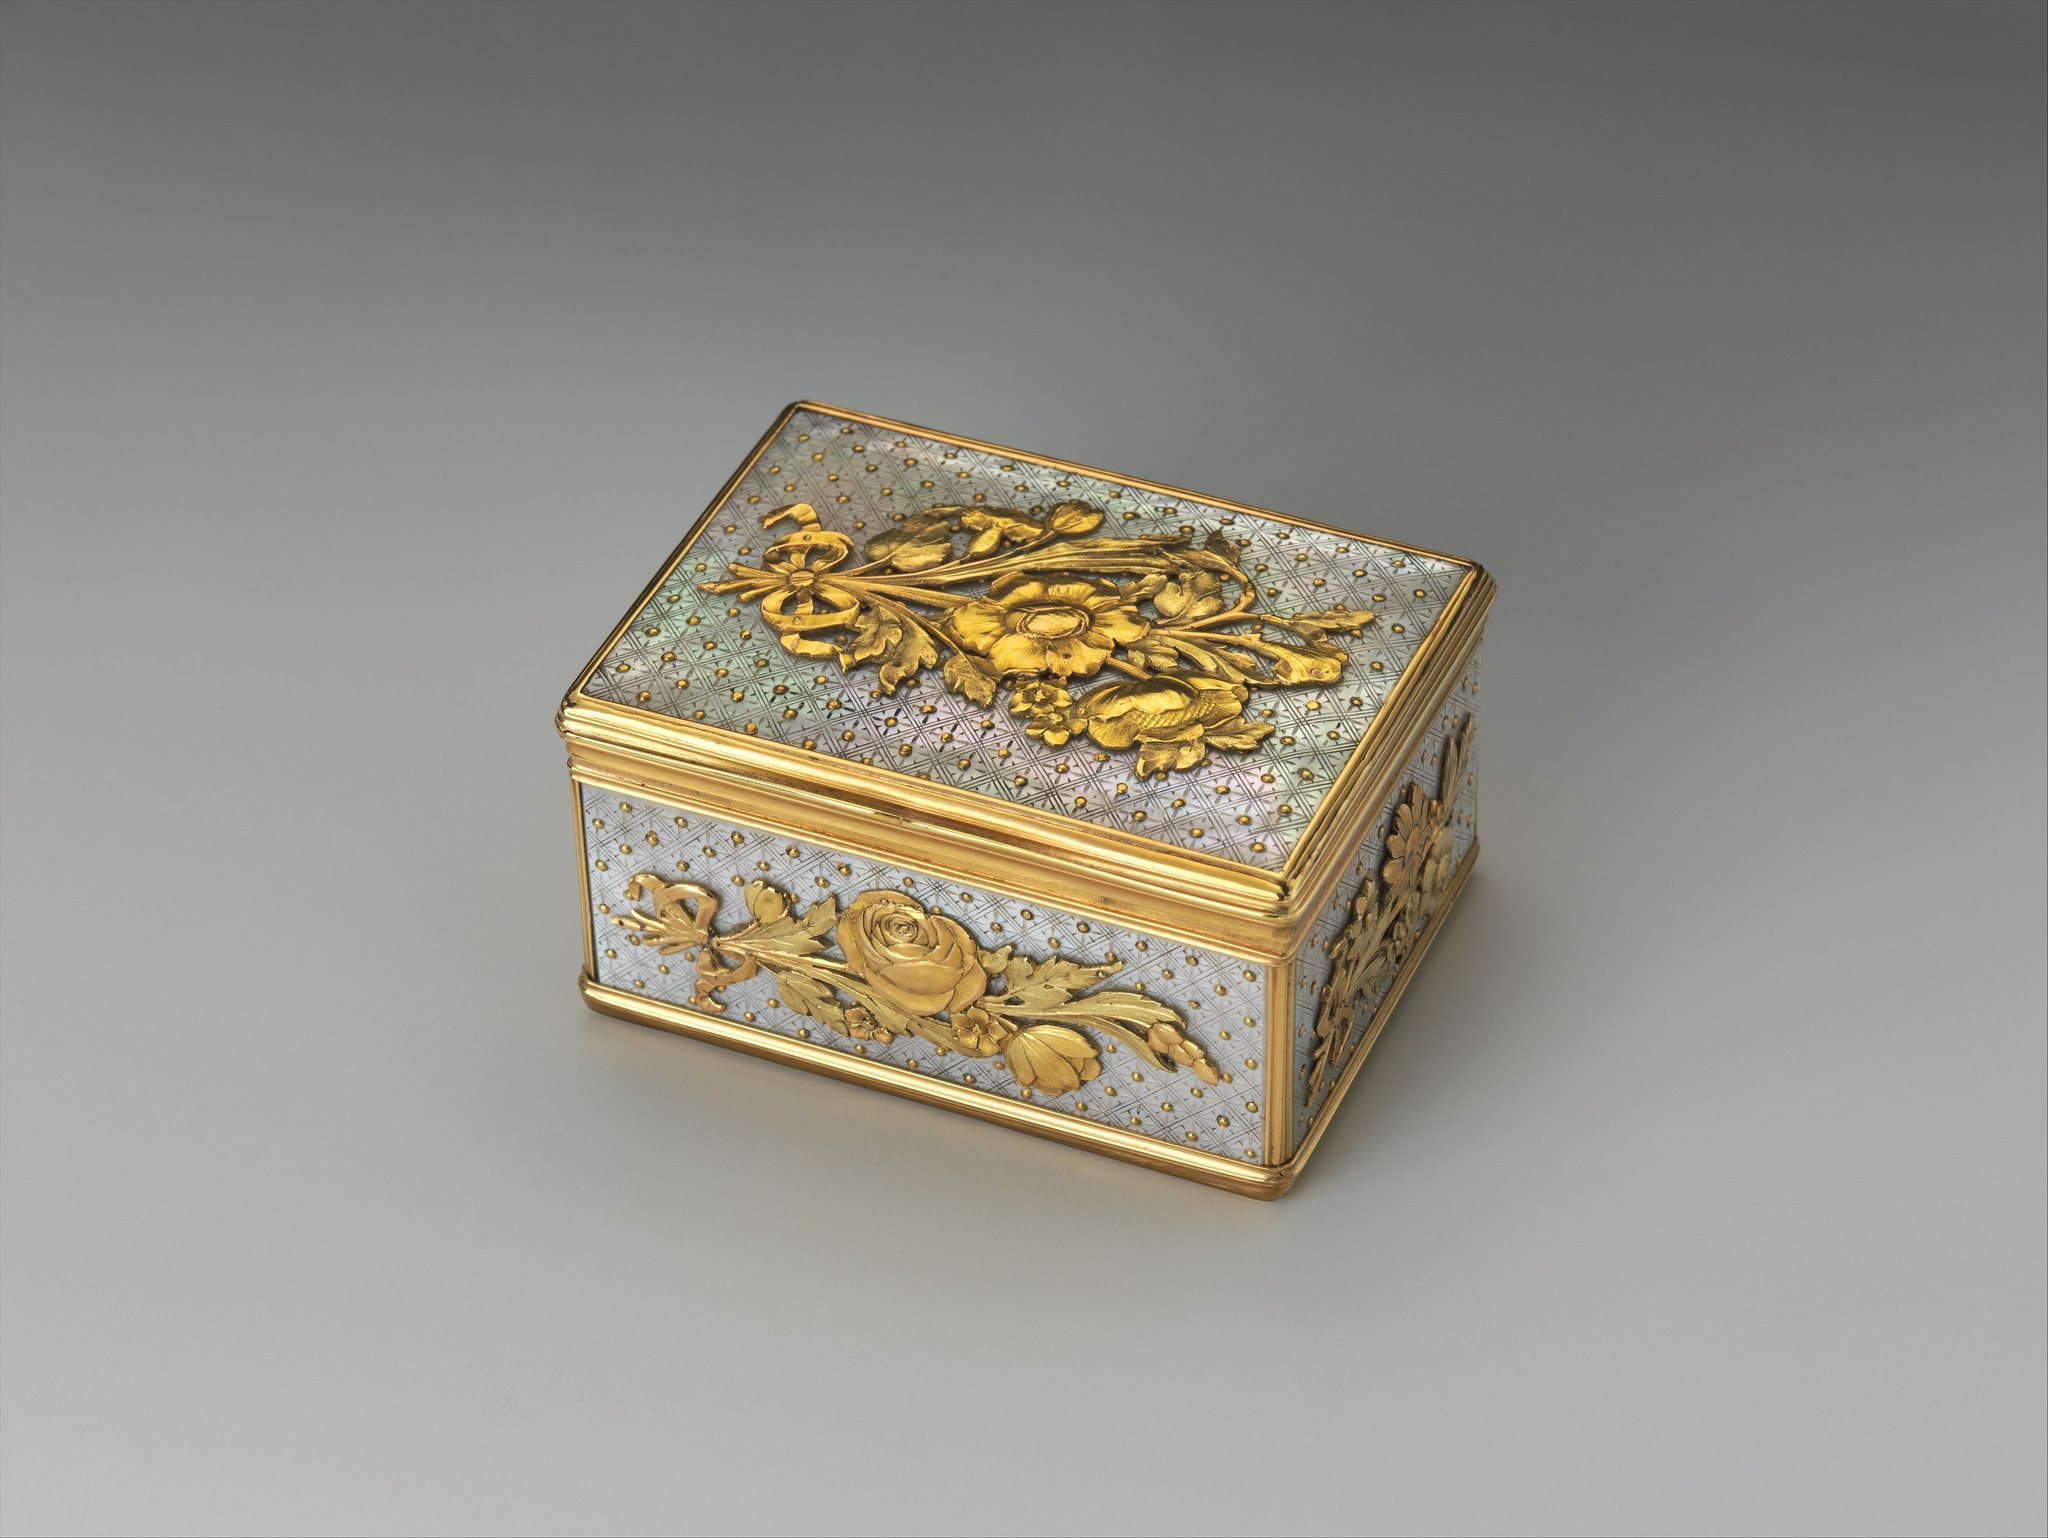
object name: snuffbox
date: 1738-1744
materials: gold, mother of pearl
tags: flowers